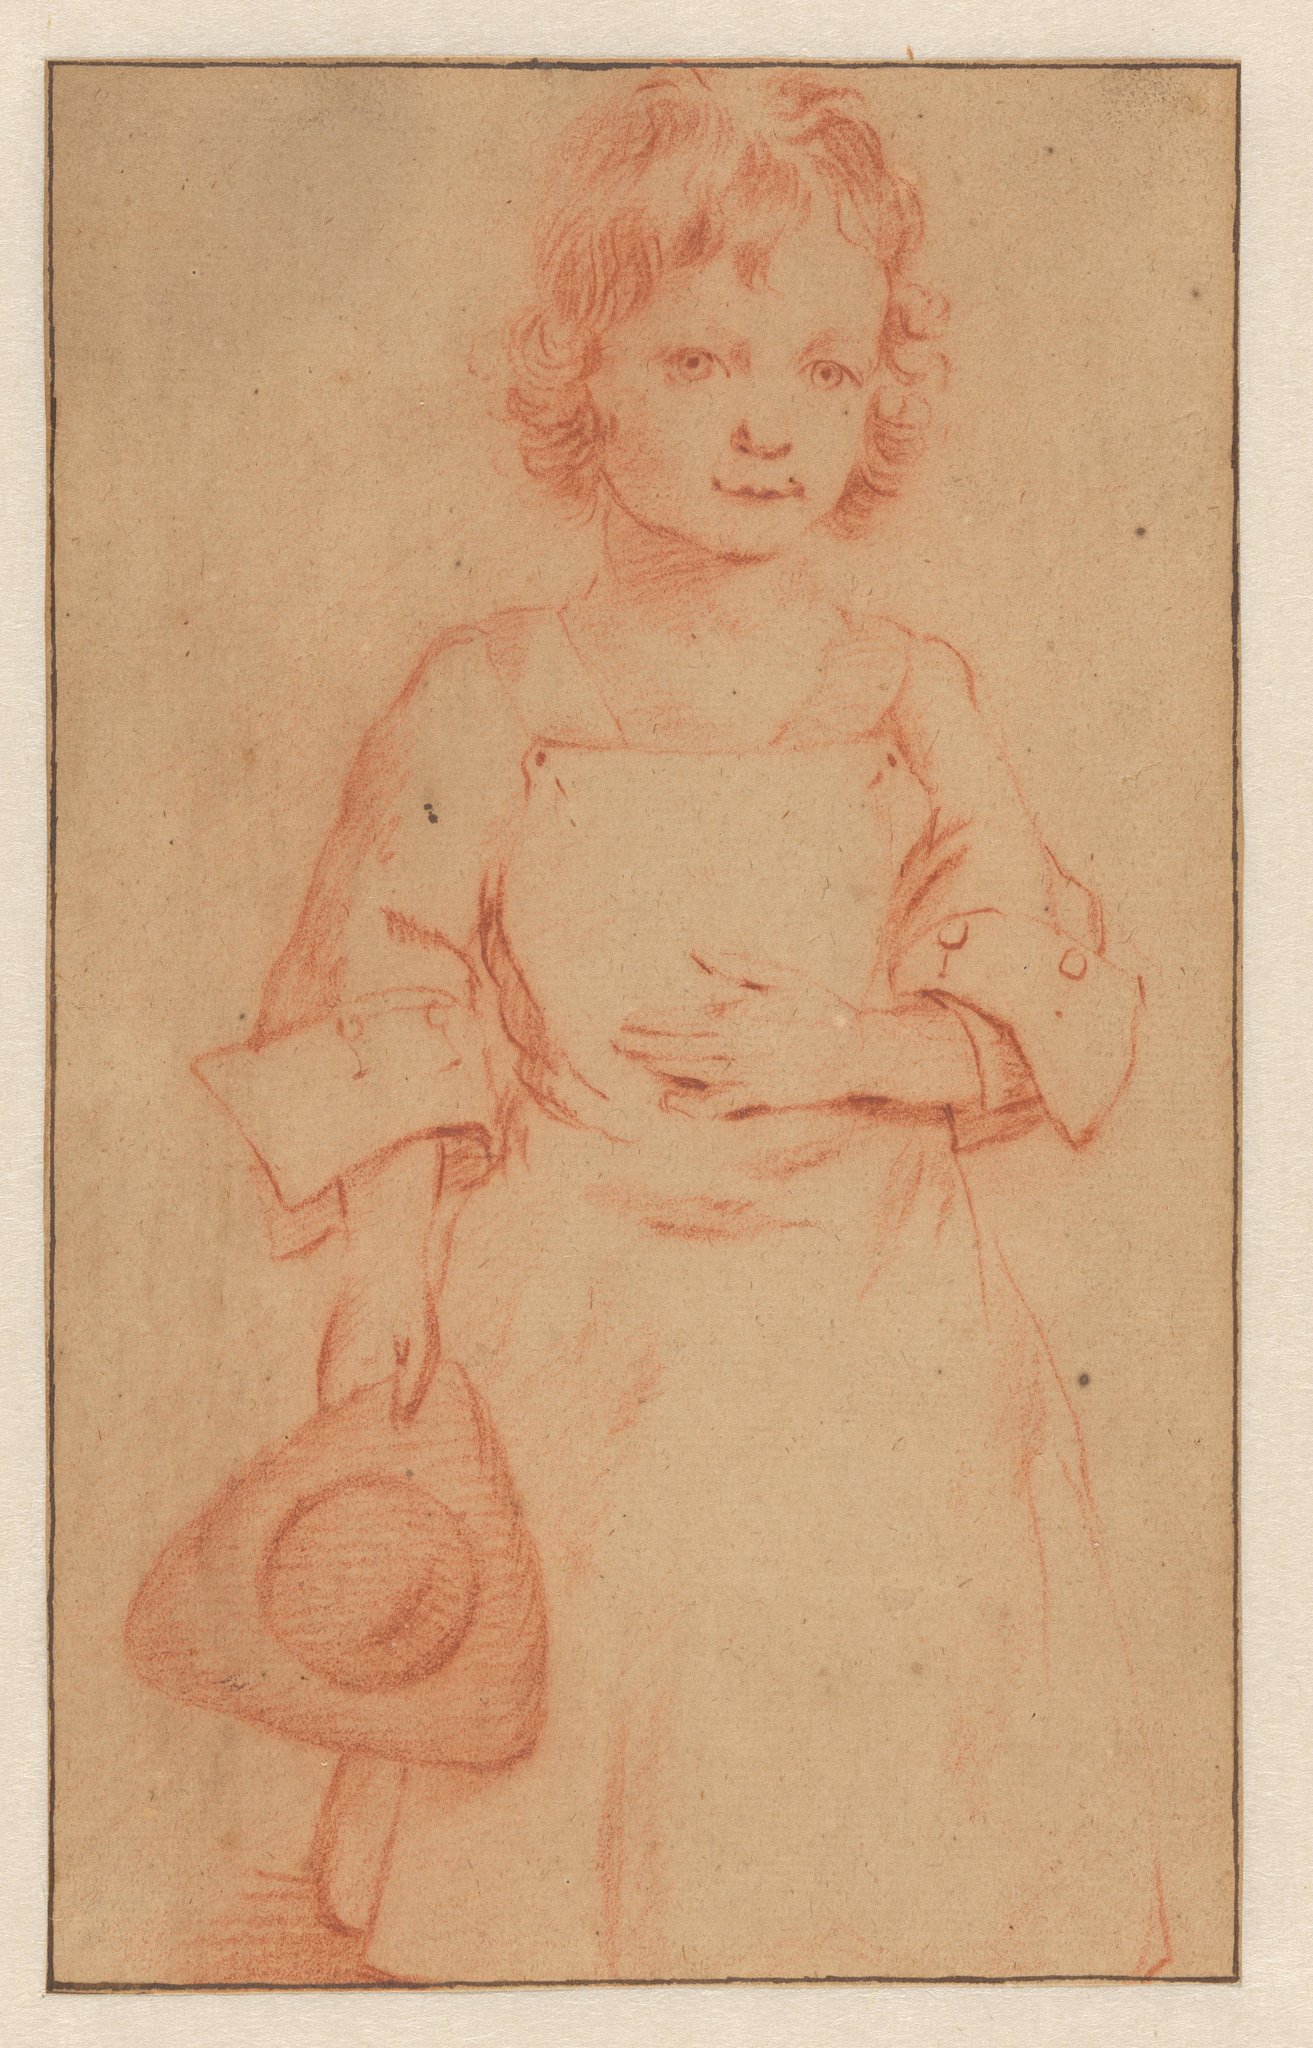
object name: drawing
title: Portret van Simon Fokke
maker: cornelis troost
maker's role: draughtsman, painter, print maker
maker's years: 1696-1750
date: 1716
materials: chalk, paper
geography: amsterdam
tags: amsterdam, print maker, draughtsman, simon fokke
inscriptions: collector's mark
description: Portrait of a standing child seen from the front. The child holds a tricorn hat in his right hand, while holding his left hand to the chest.